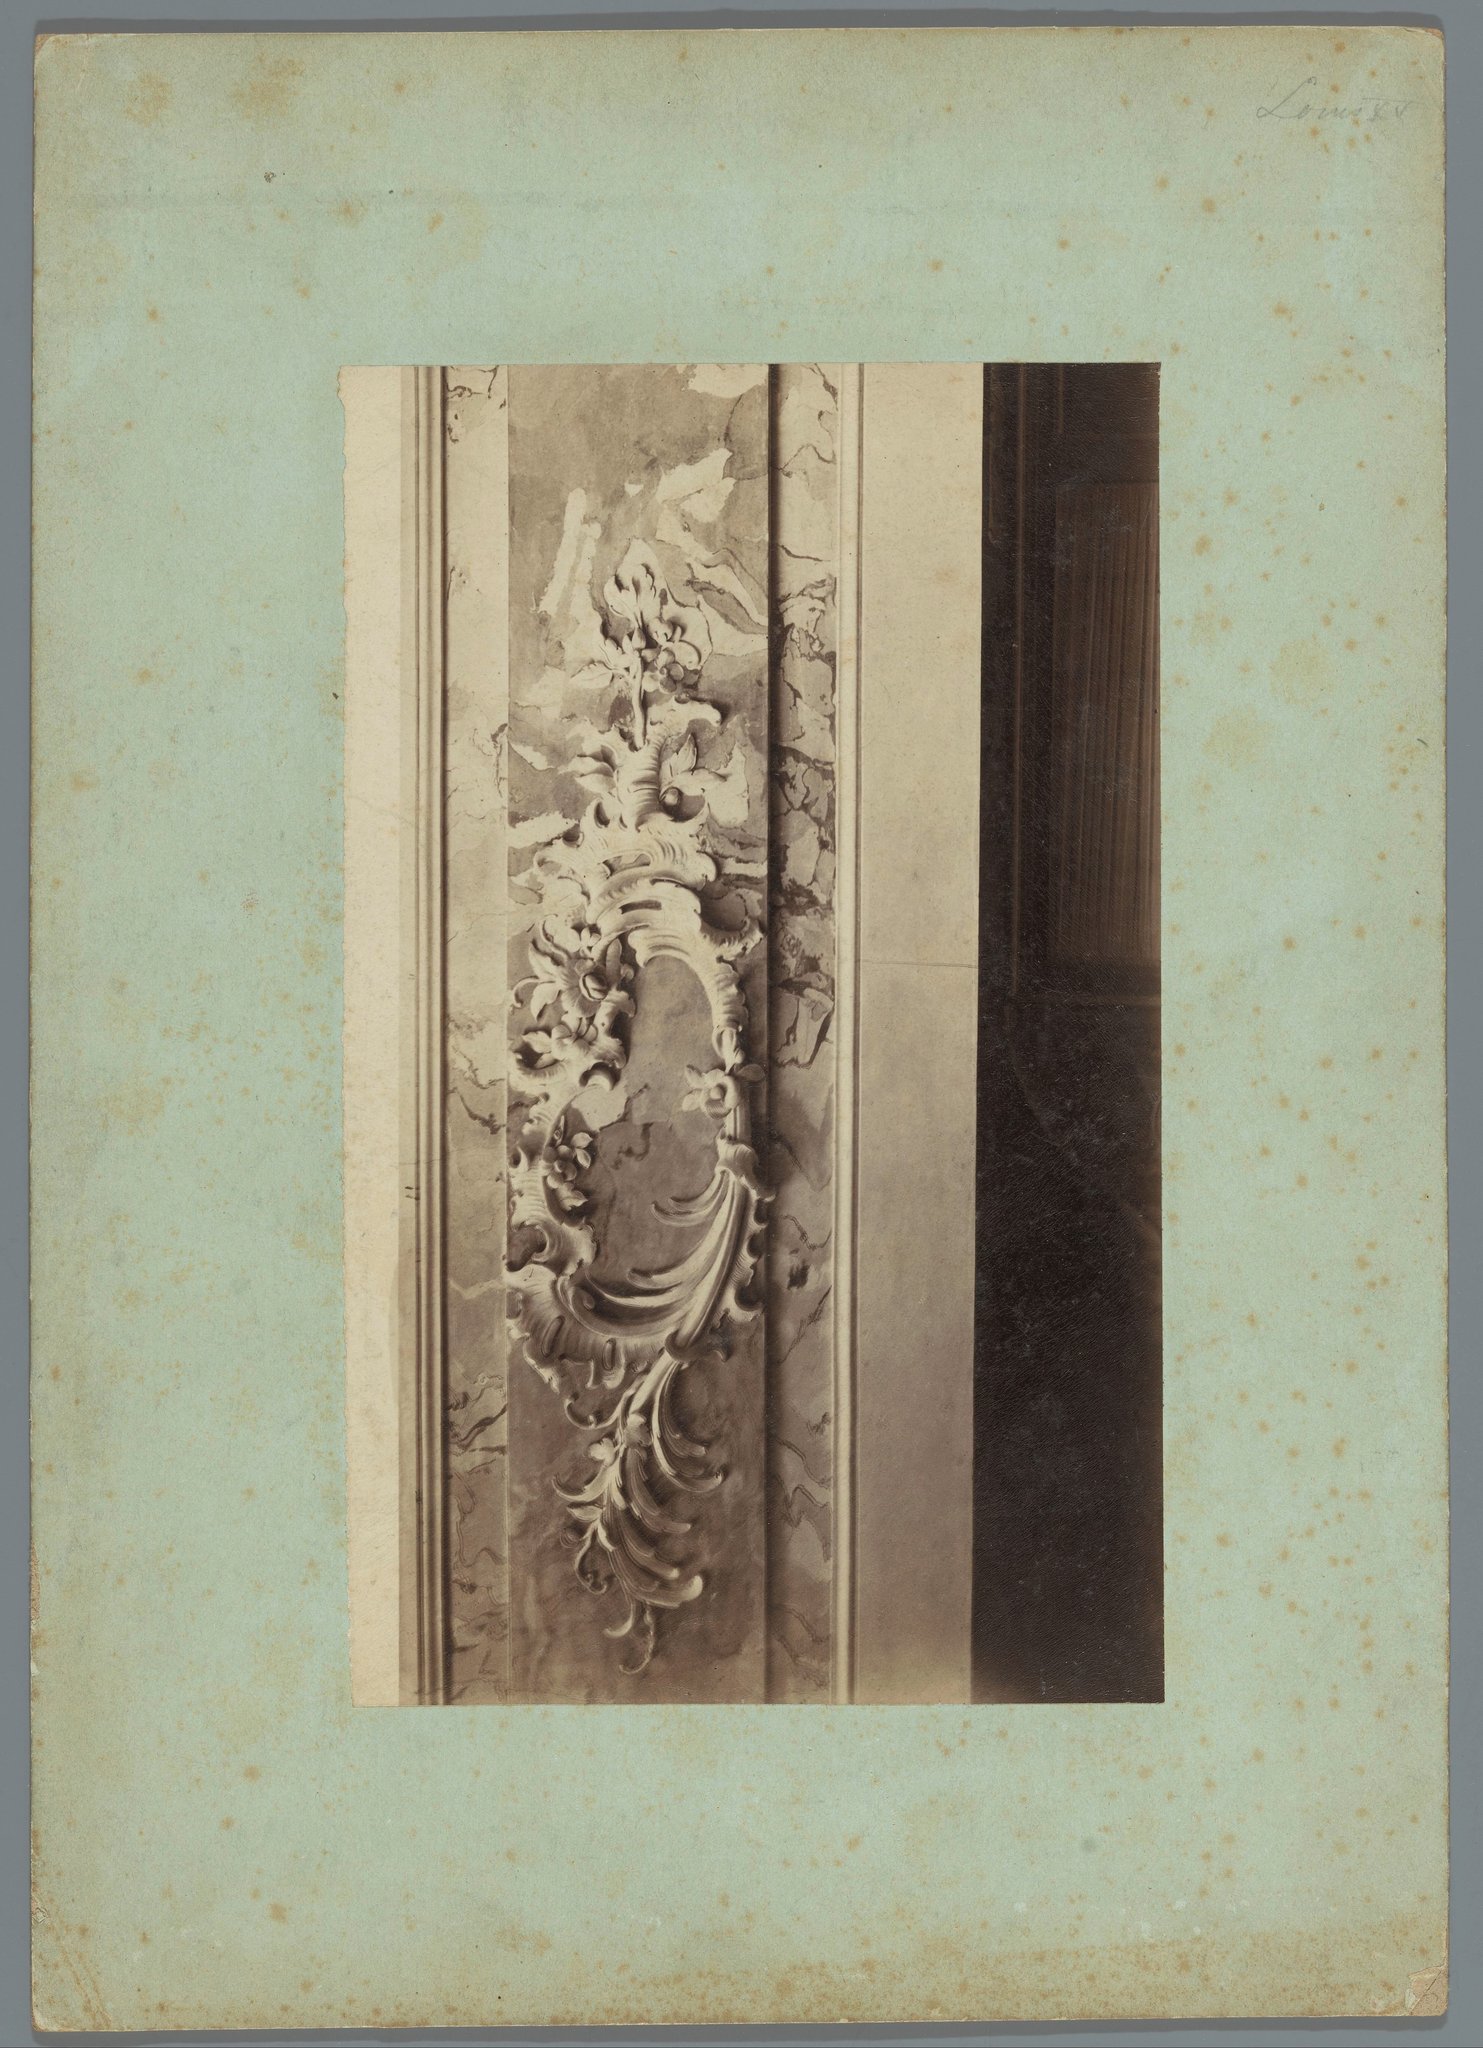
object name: photograph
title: Ornament (vermoedelijk) op een muur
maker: Anonymous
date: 1875-1900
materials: cardboard, photographic support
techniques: albumen print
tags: ornament ~ arabesque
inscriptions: inscription: ‘Louis XV’, inscription: ‘pl 15’, collector's mark: Lugt 3937